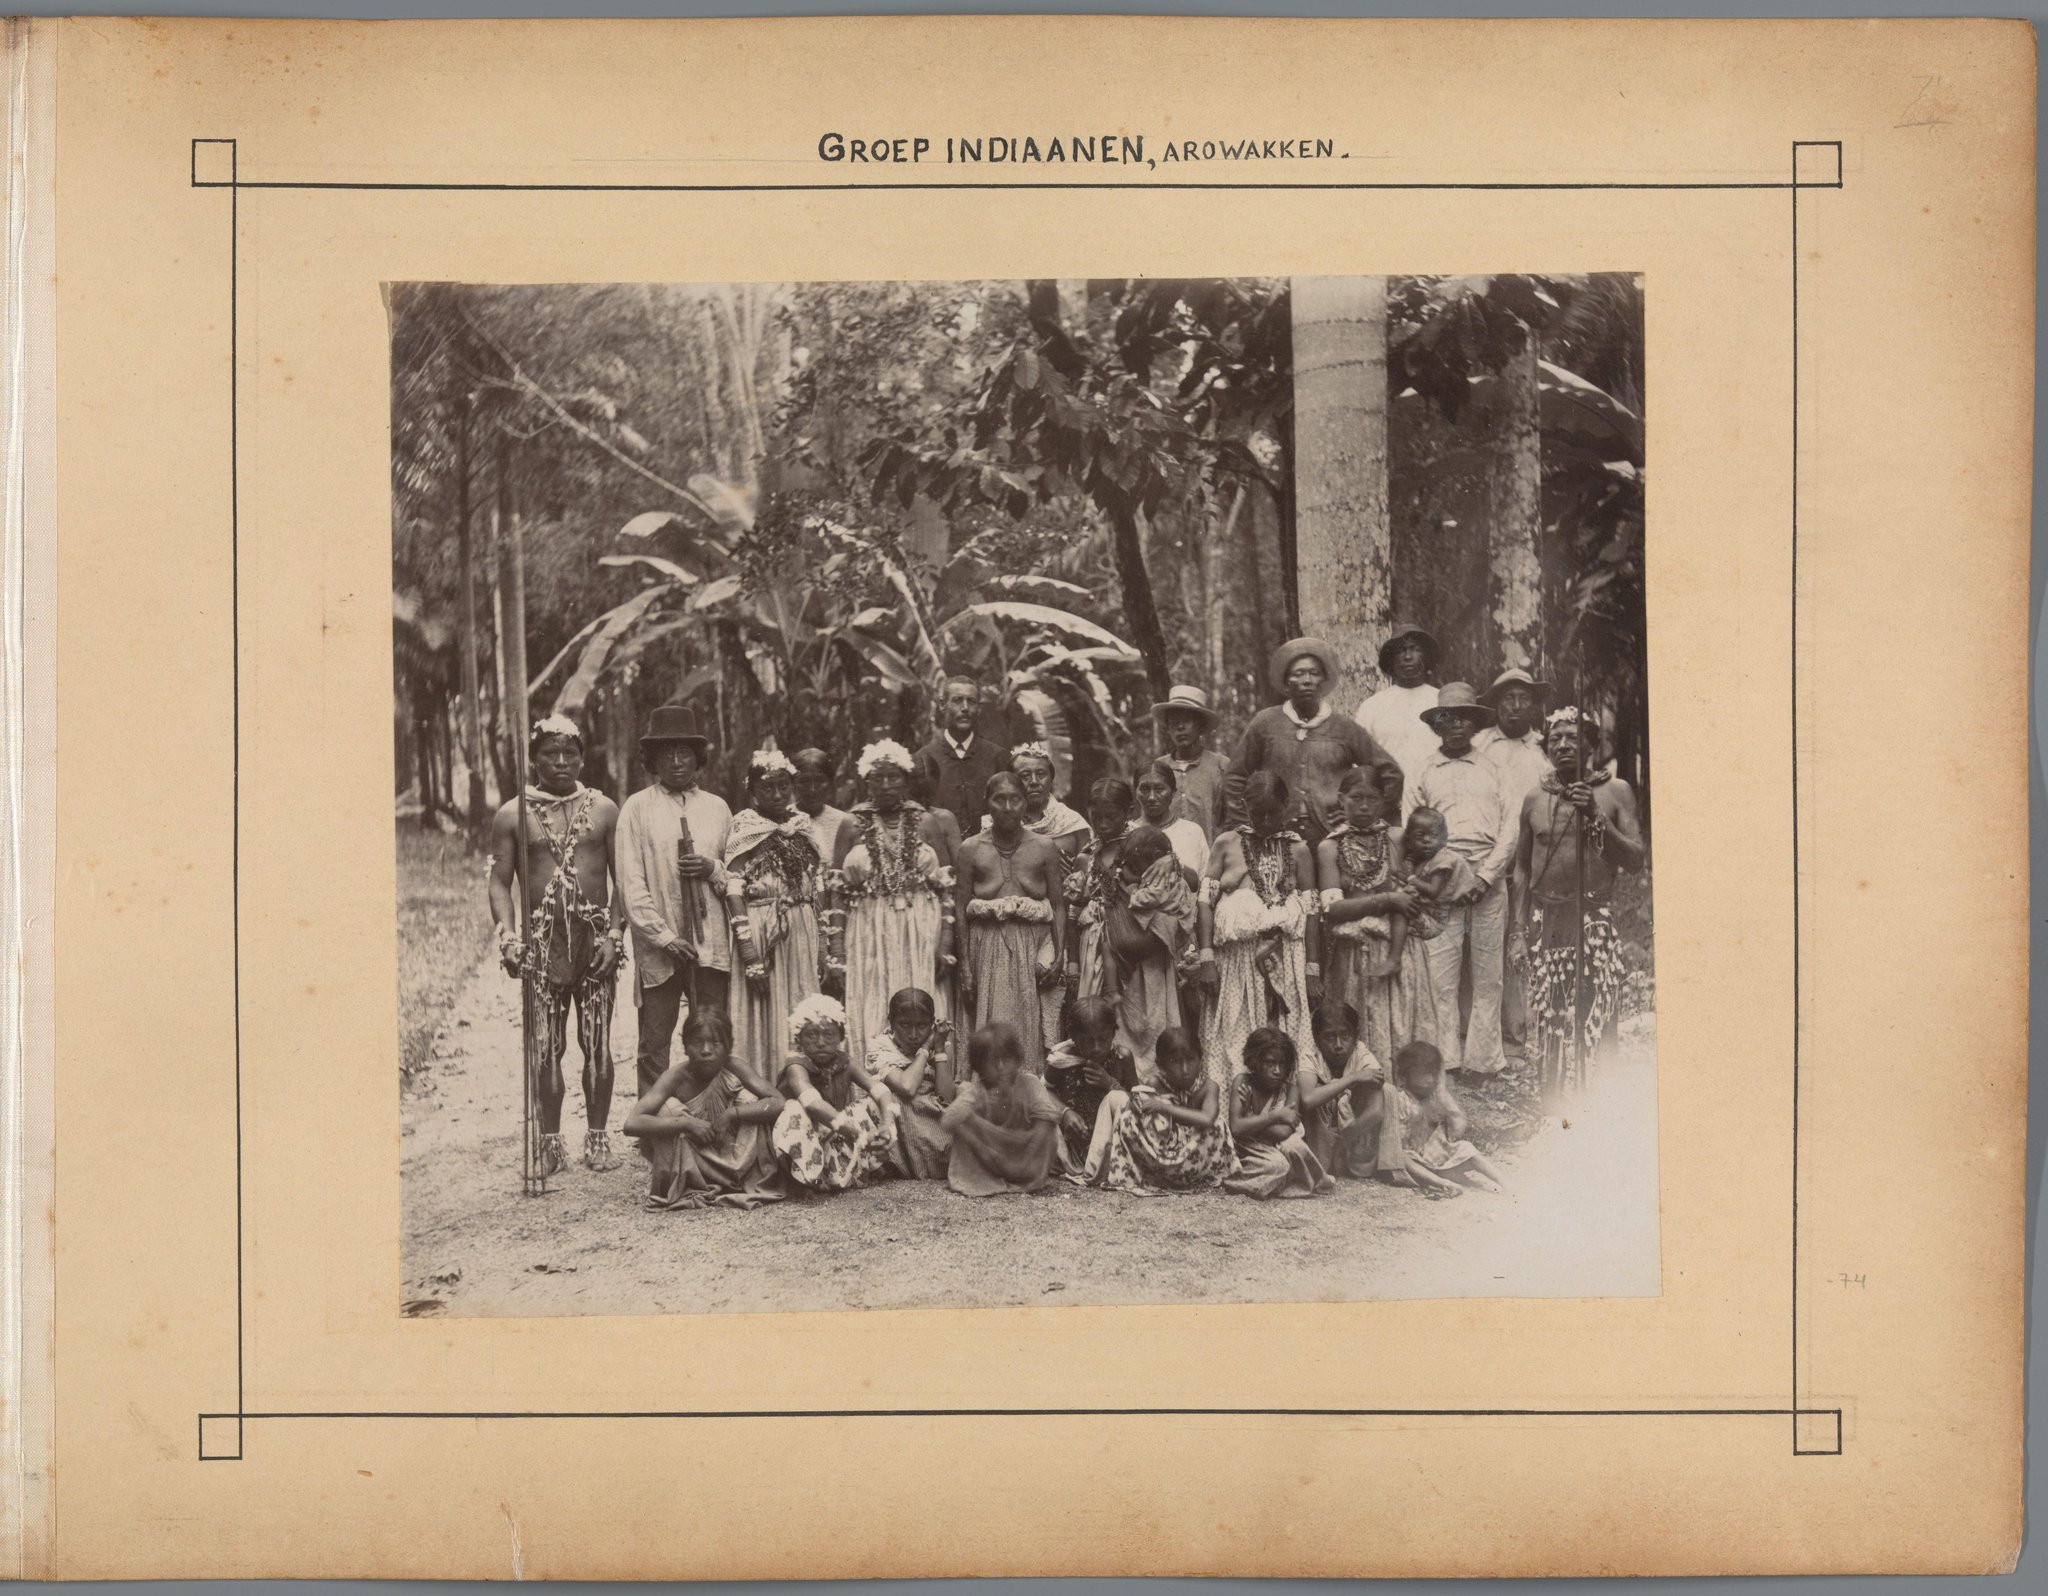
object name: photograph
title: Groep Indiaanen, Arowakken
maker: julius muller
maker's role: official, politician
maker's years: 1846-1902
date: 1898-1902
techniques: albumen print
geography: suriname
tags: suriname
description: Groep Surinaamse Arowakken, poserend in feestkleding in de Gouvernementstuin in Paramaribo, waarschijnlijk ter gelegenheid van een optocht tijdens een koninklijke verjaardag.